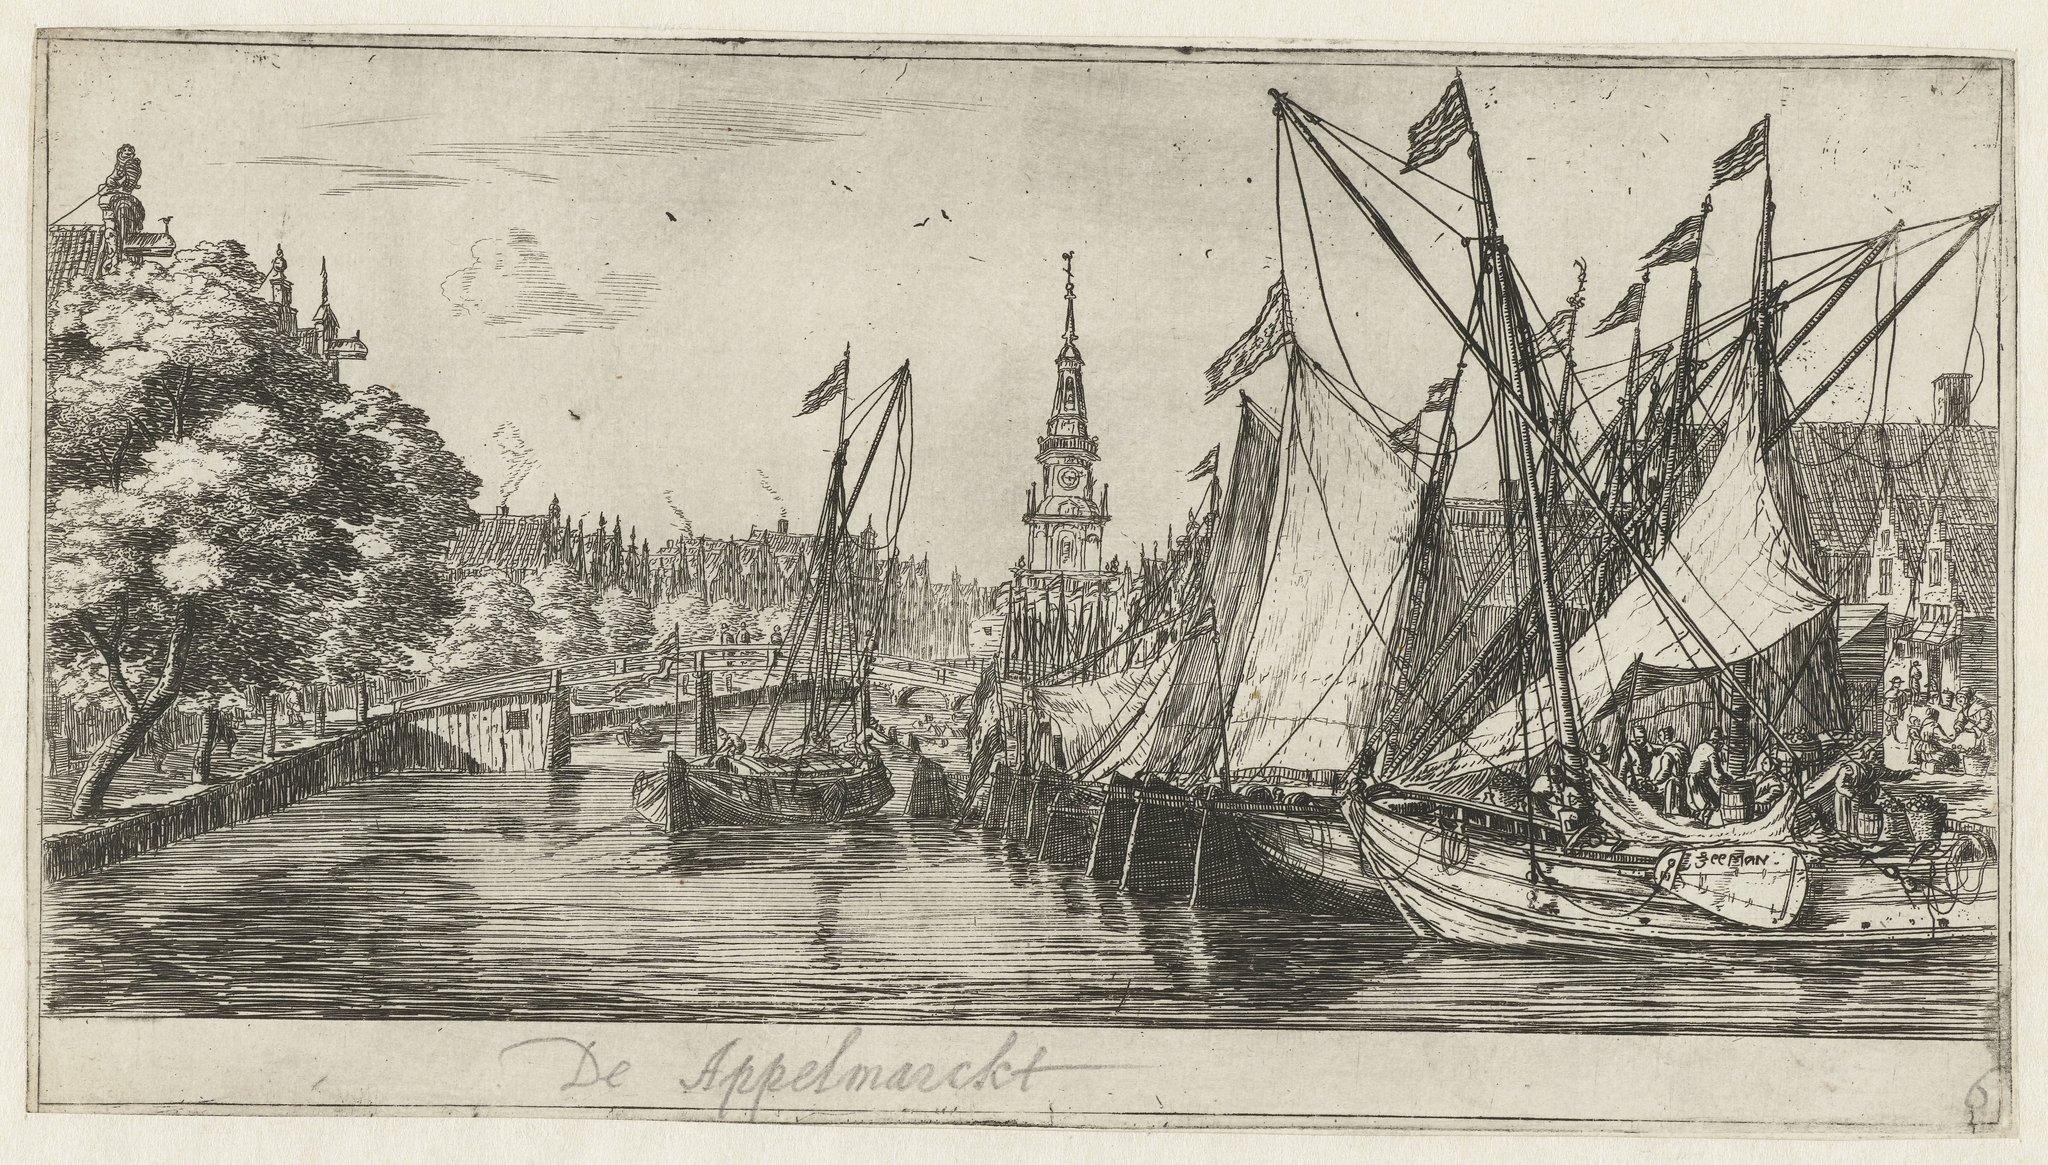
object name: print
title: Verscheide gesichten binnen Amsterdam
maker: reinier nooms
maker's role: draughtsman, painter, print maker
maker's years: 1623-1664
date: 1657-1661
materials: paper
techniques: etching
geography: low countries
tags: city-view in general; 'veduta'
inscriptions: collector's mark: Lugt 240, inscription: ‘zeeman’, inscription: ‘De Appelmarckt’, number: ‘6’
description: De Appelmarkt, gezien in noordelijke richting naar de bruggen voor de Raamsteeg-Oude Spiegelstraat en Hamsteeg-Gasthuismolensteeg. Op de achtergrond de Jan Rodenpoortstoren. Rij schepen langs de kade.